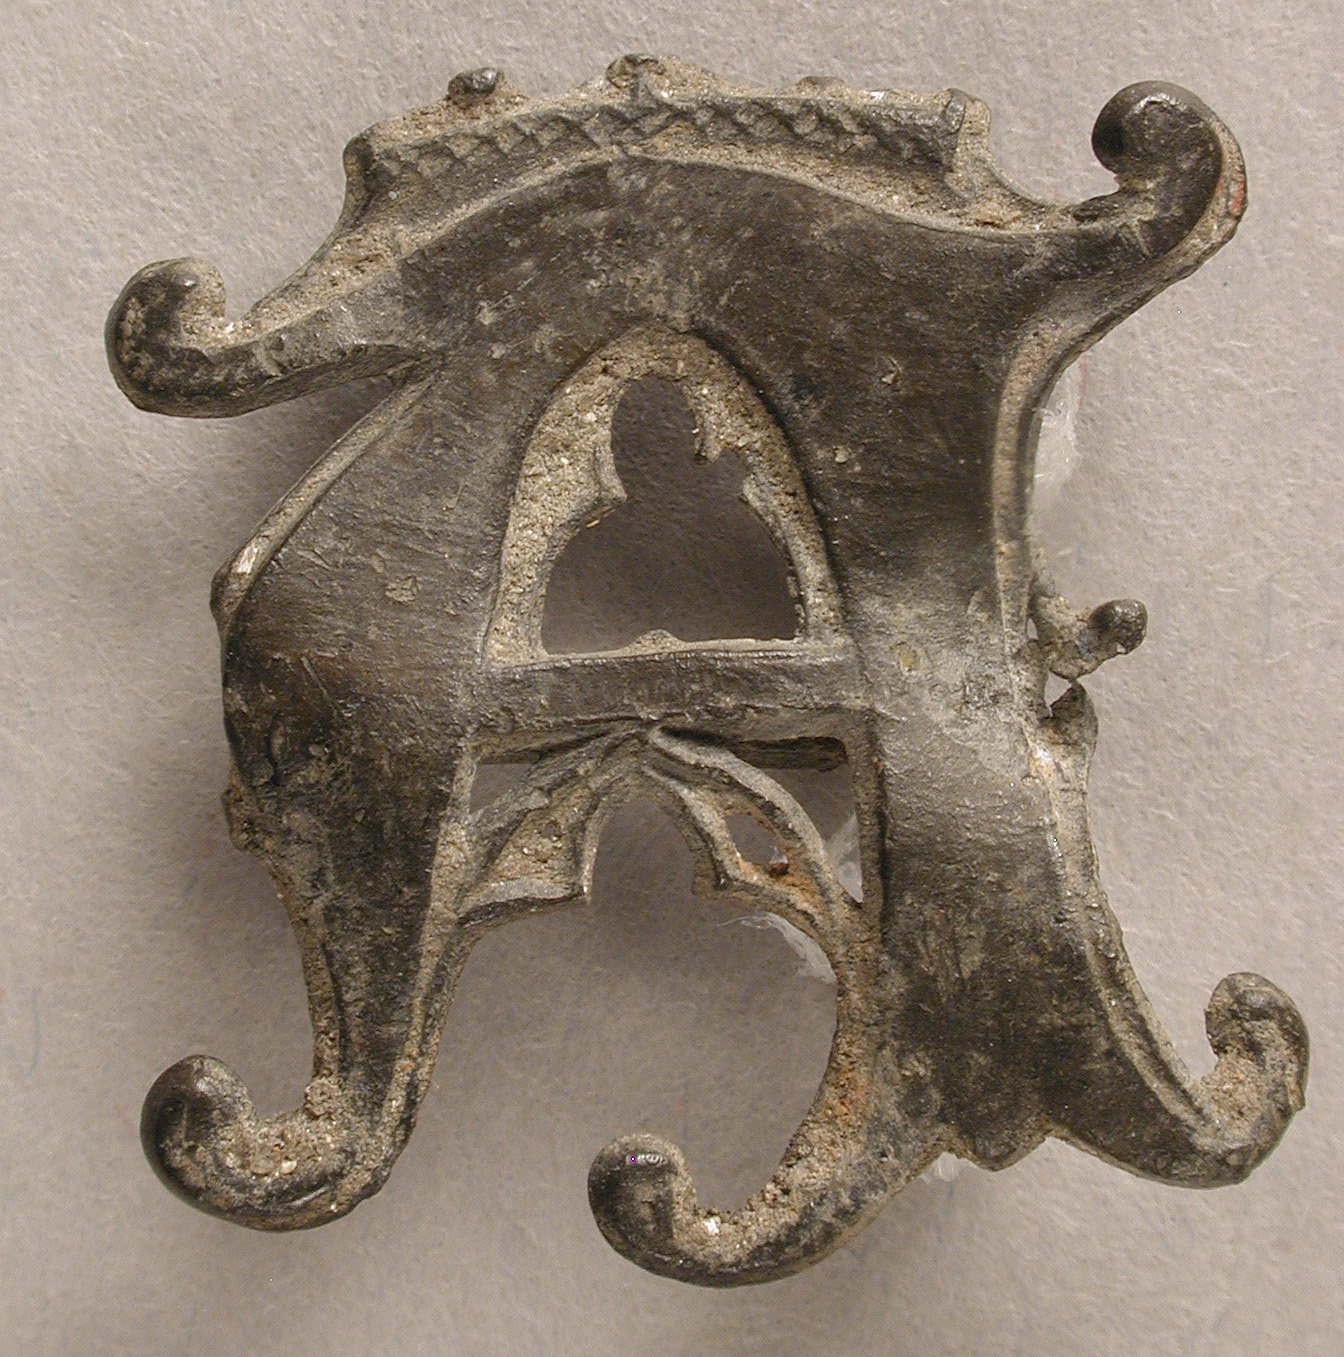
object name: pilgrim's badge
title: Badge with Crowned Letter A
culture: british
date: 1301-1500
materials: alloy, lead, tin